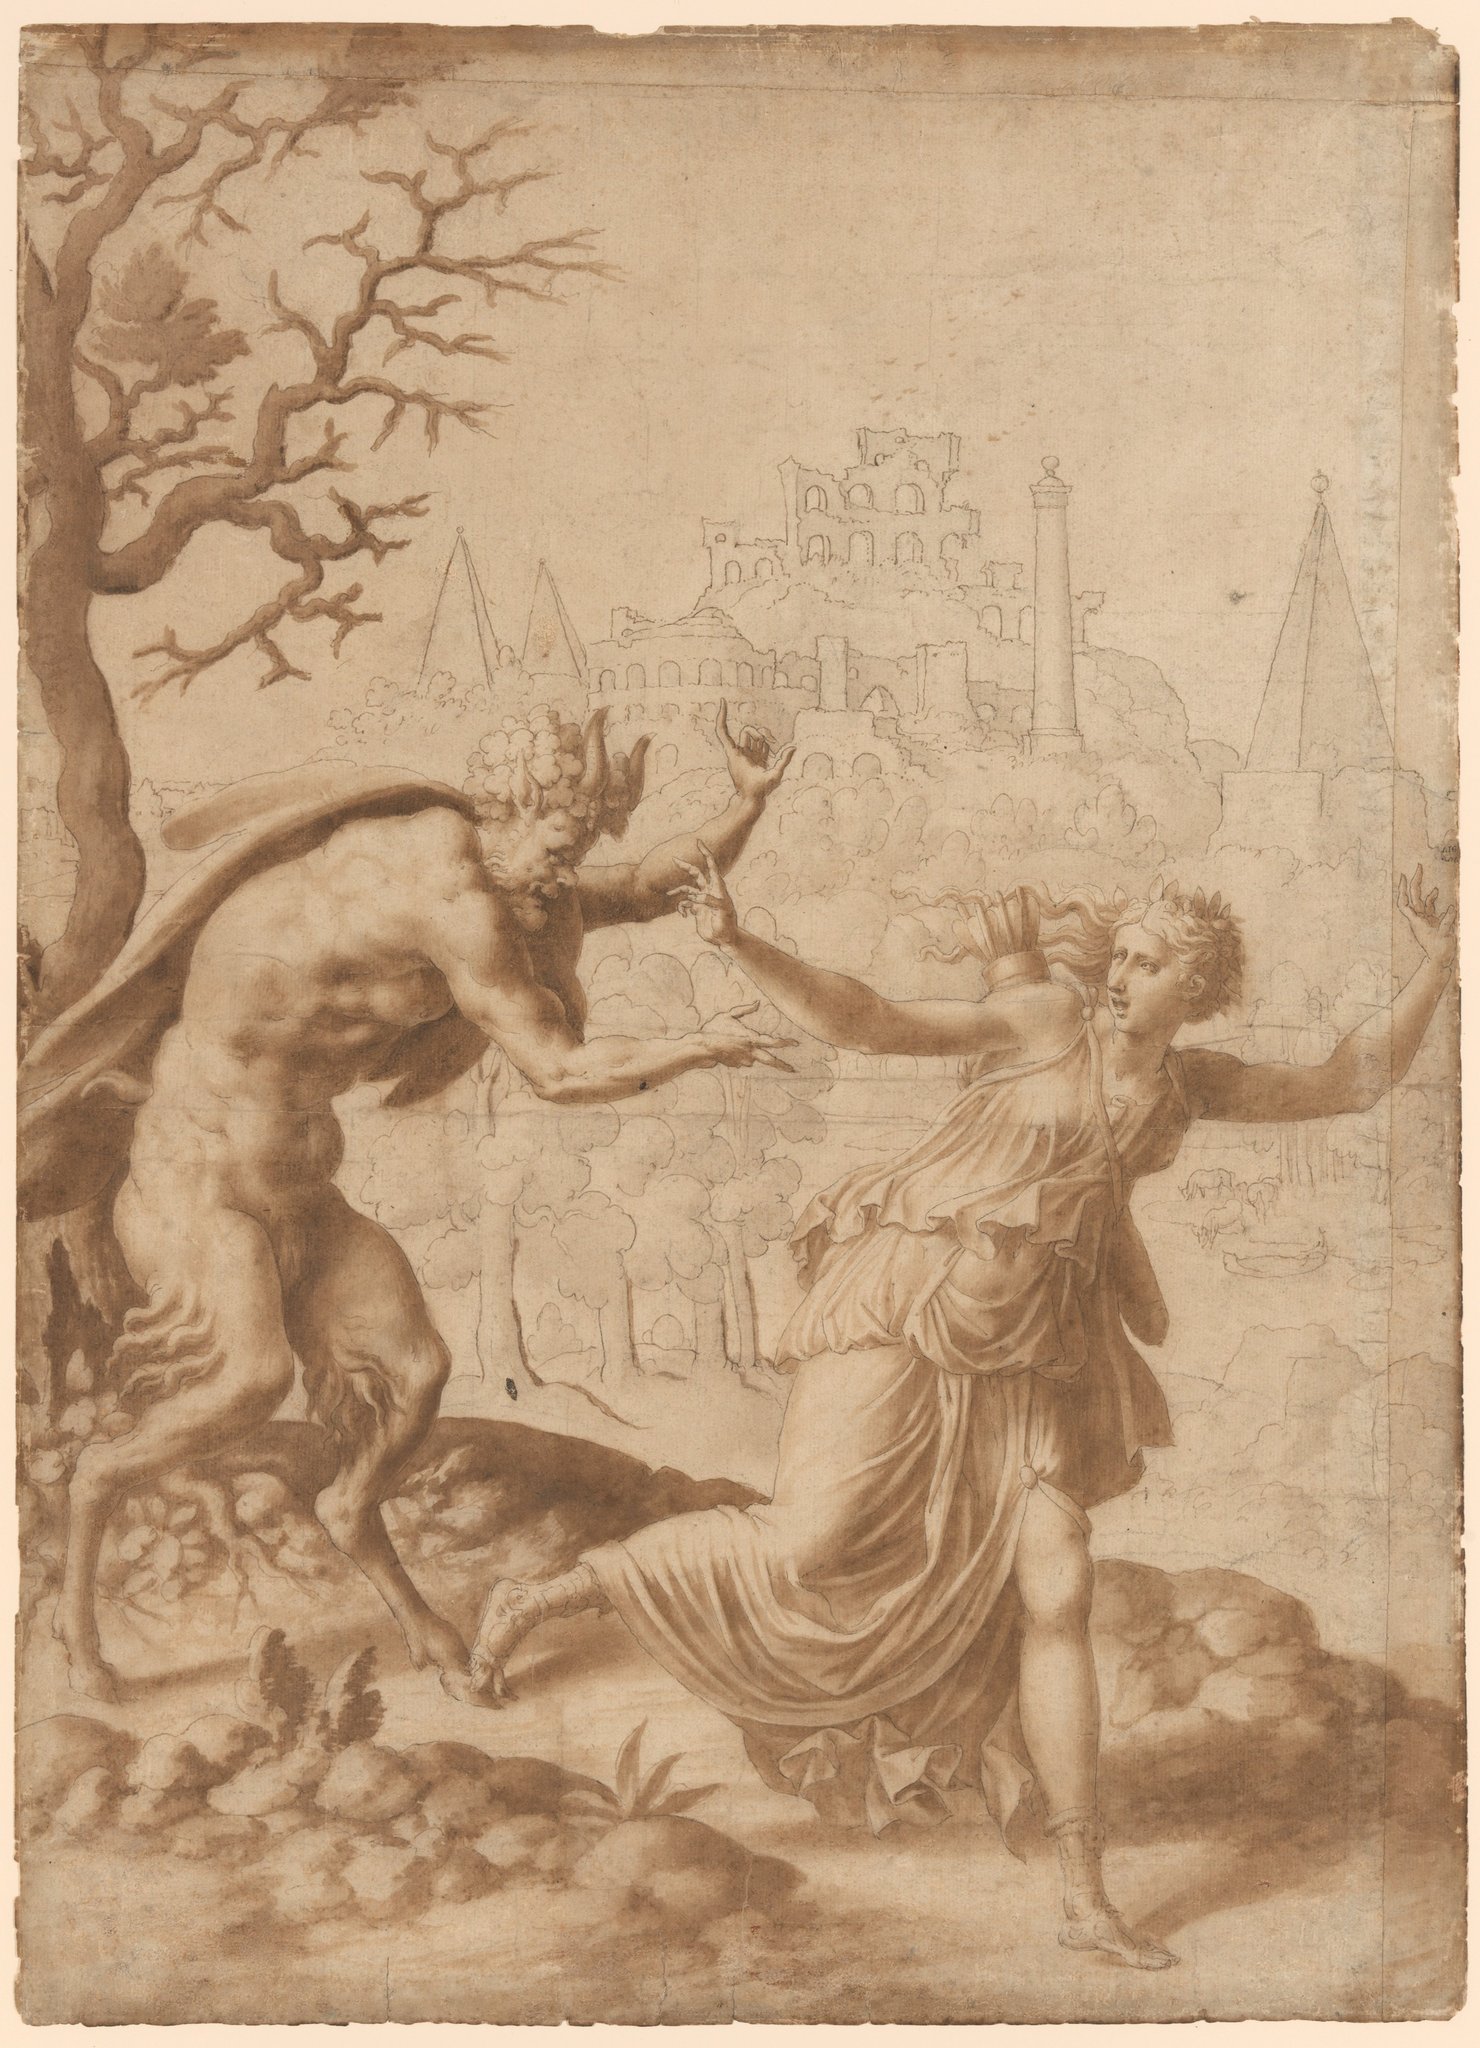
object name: drawing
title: A Satyr Pursuing a Nymph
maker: anonymous, french, school of fontainebleau, 16th century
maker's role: artist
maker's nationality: french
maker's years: 1500-1600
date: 1550-1575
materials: chalk, ink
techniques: brush, pen, wash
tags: nymphs,satyrs,trees